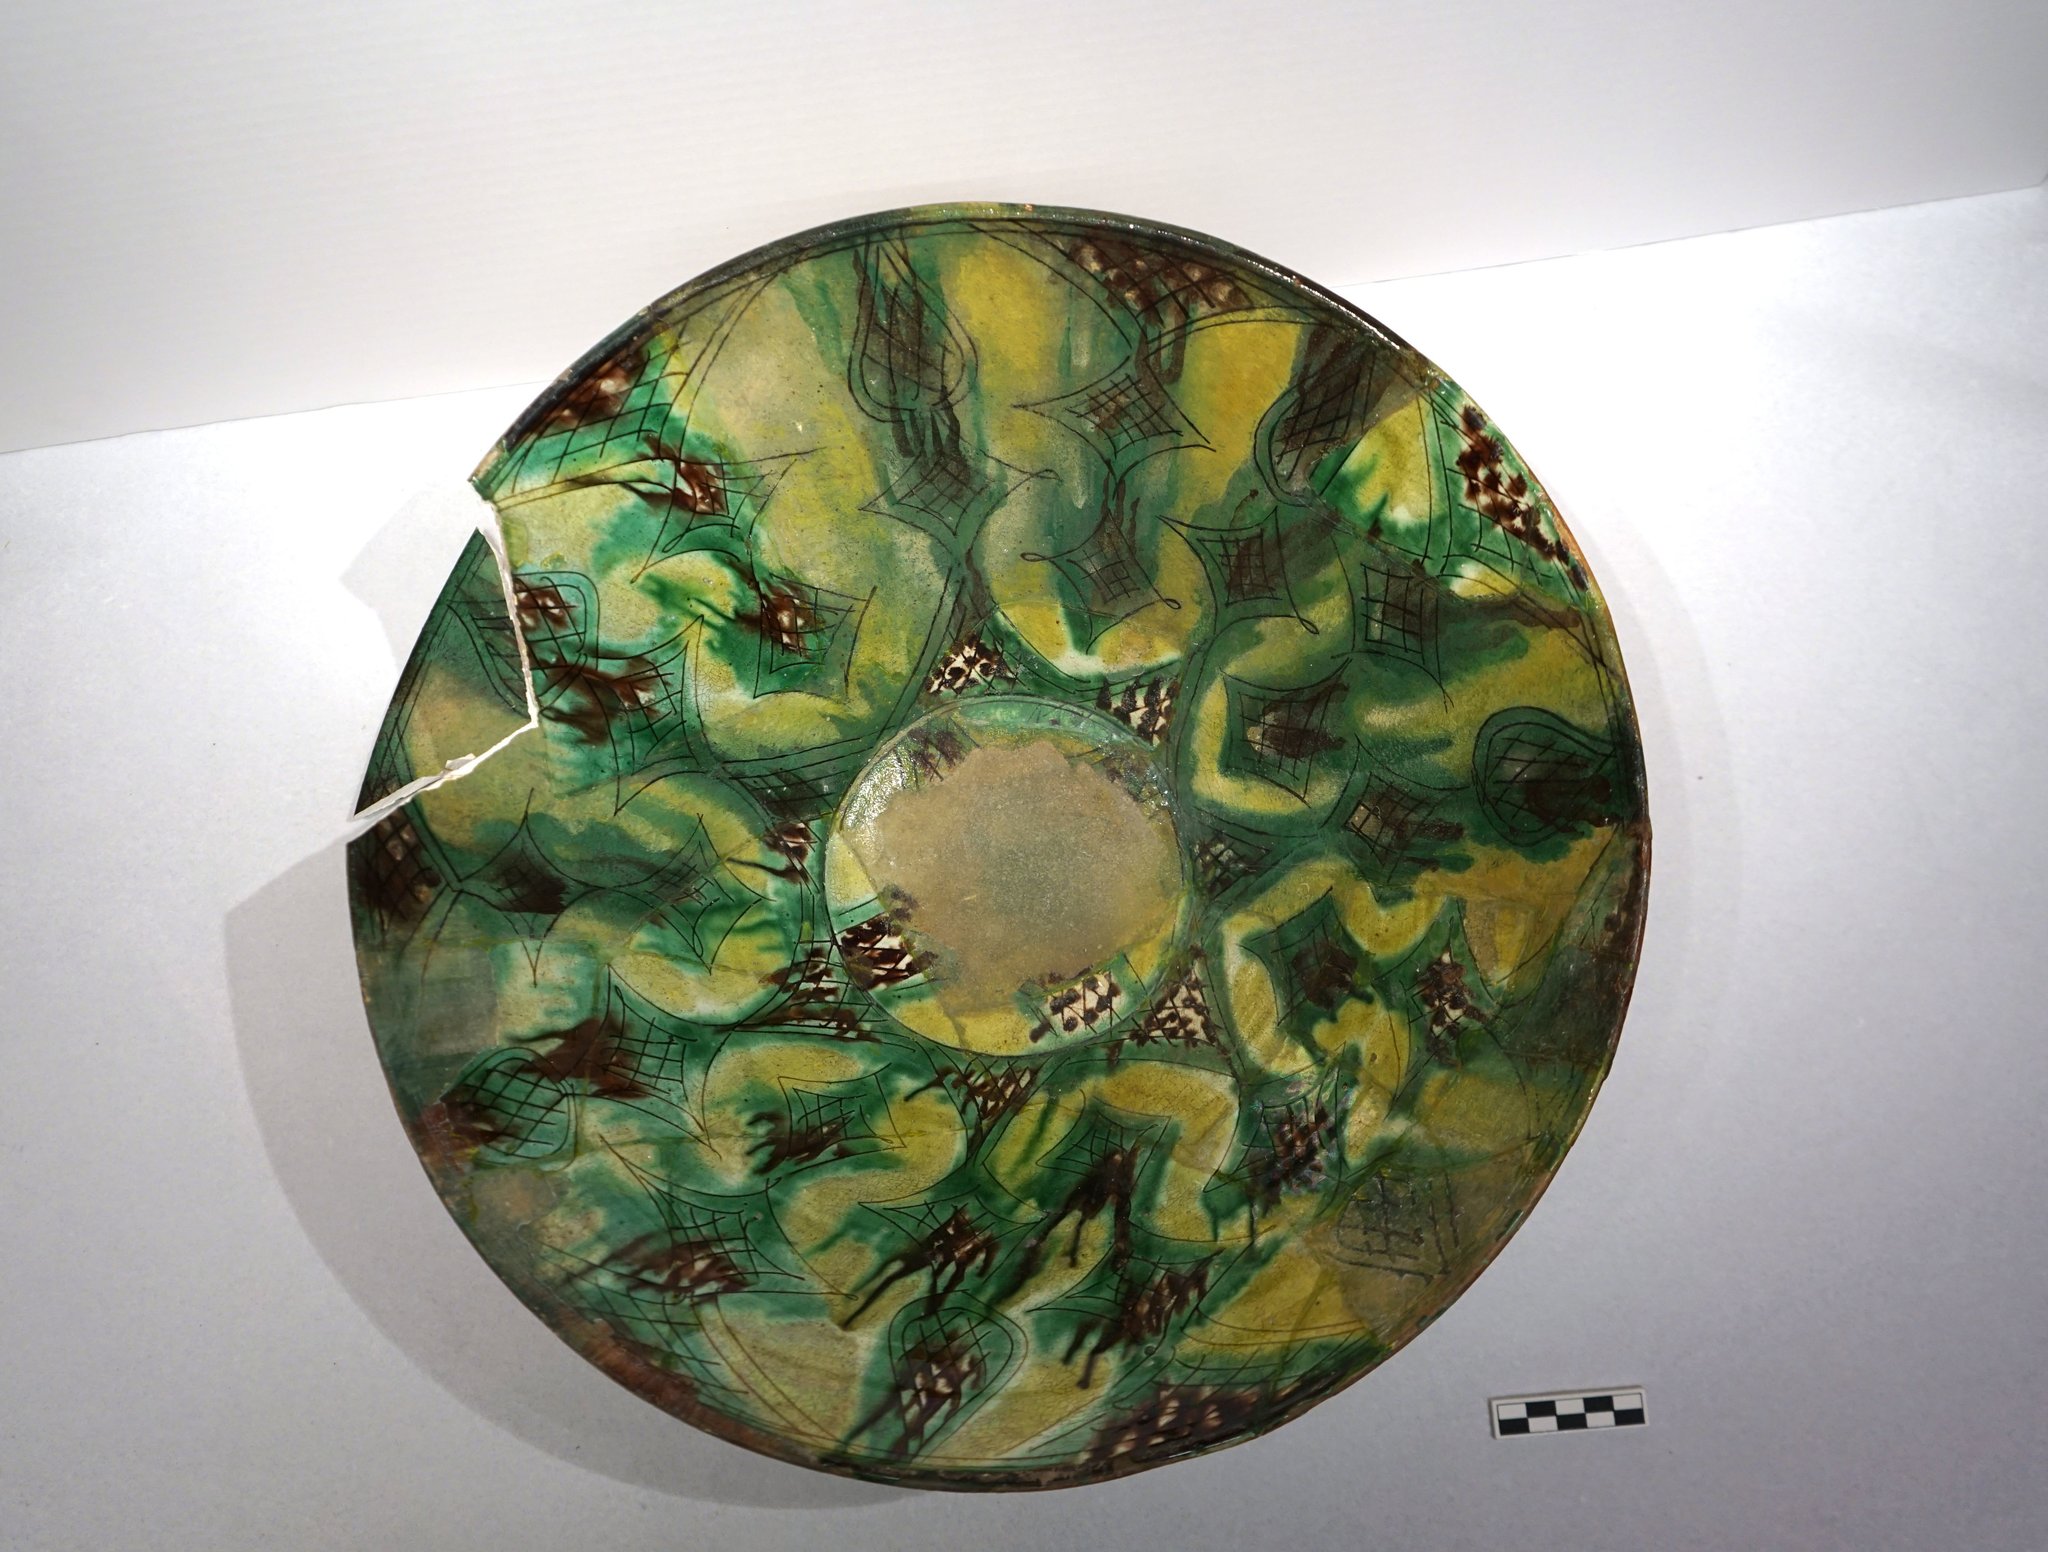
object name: bowl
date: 767-833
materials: earthenware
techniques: glazing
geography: iran